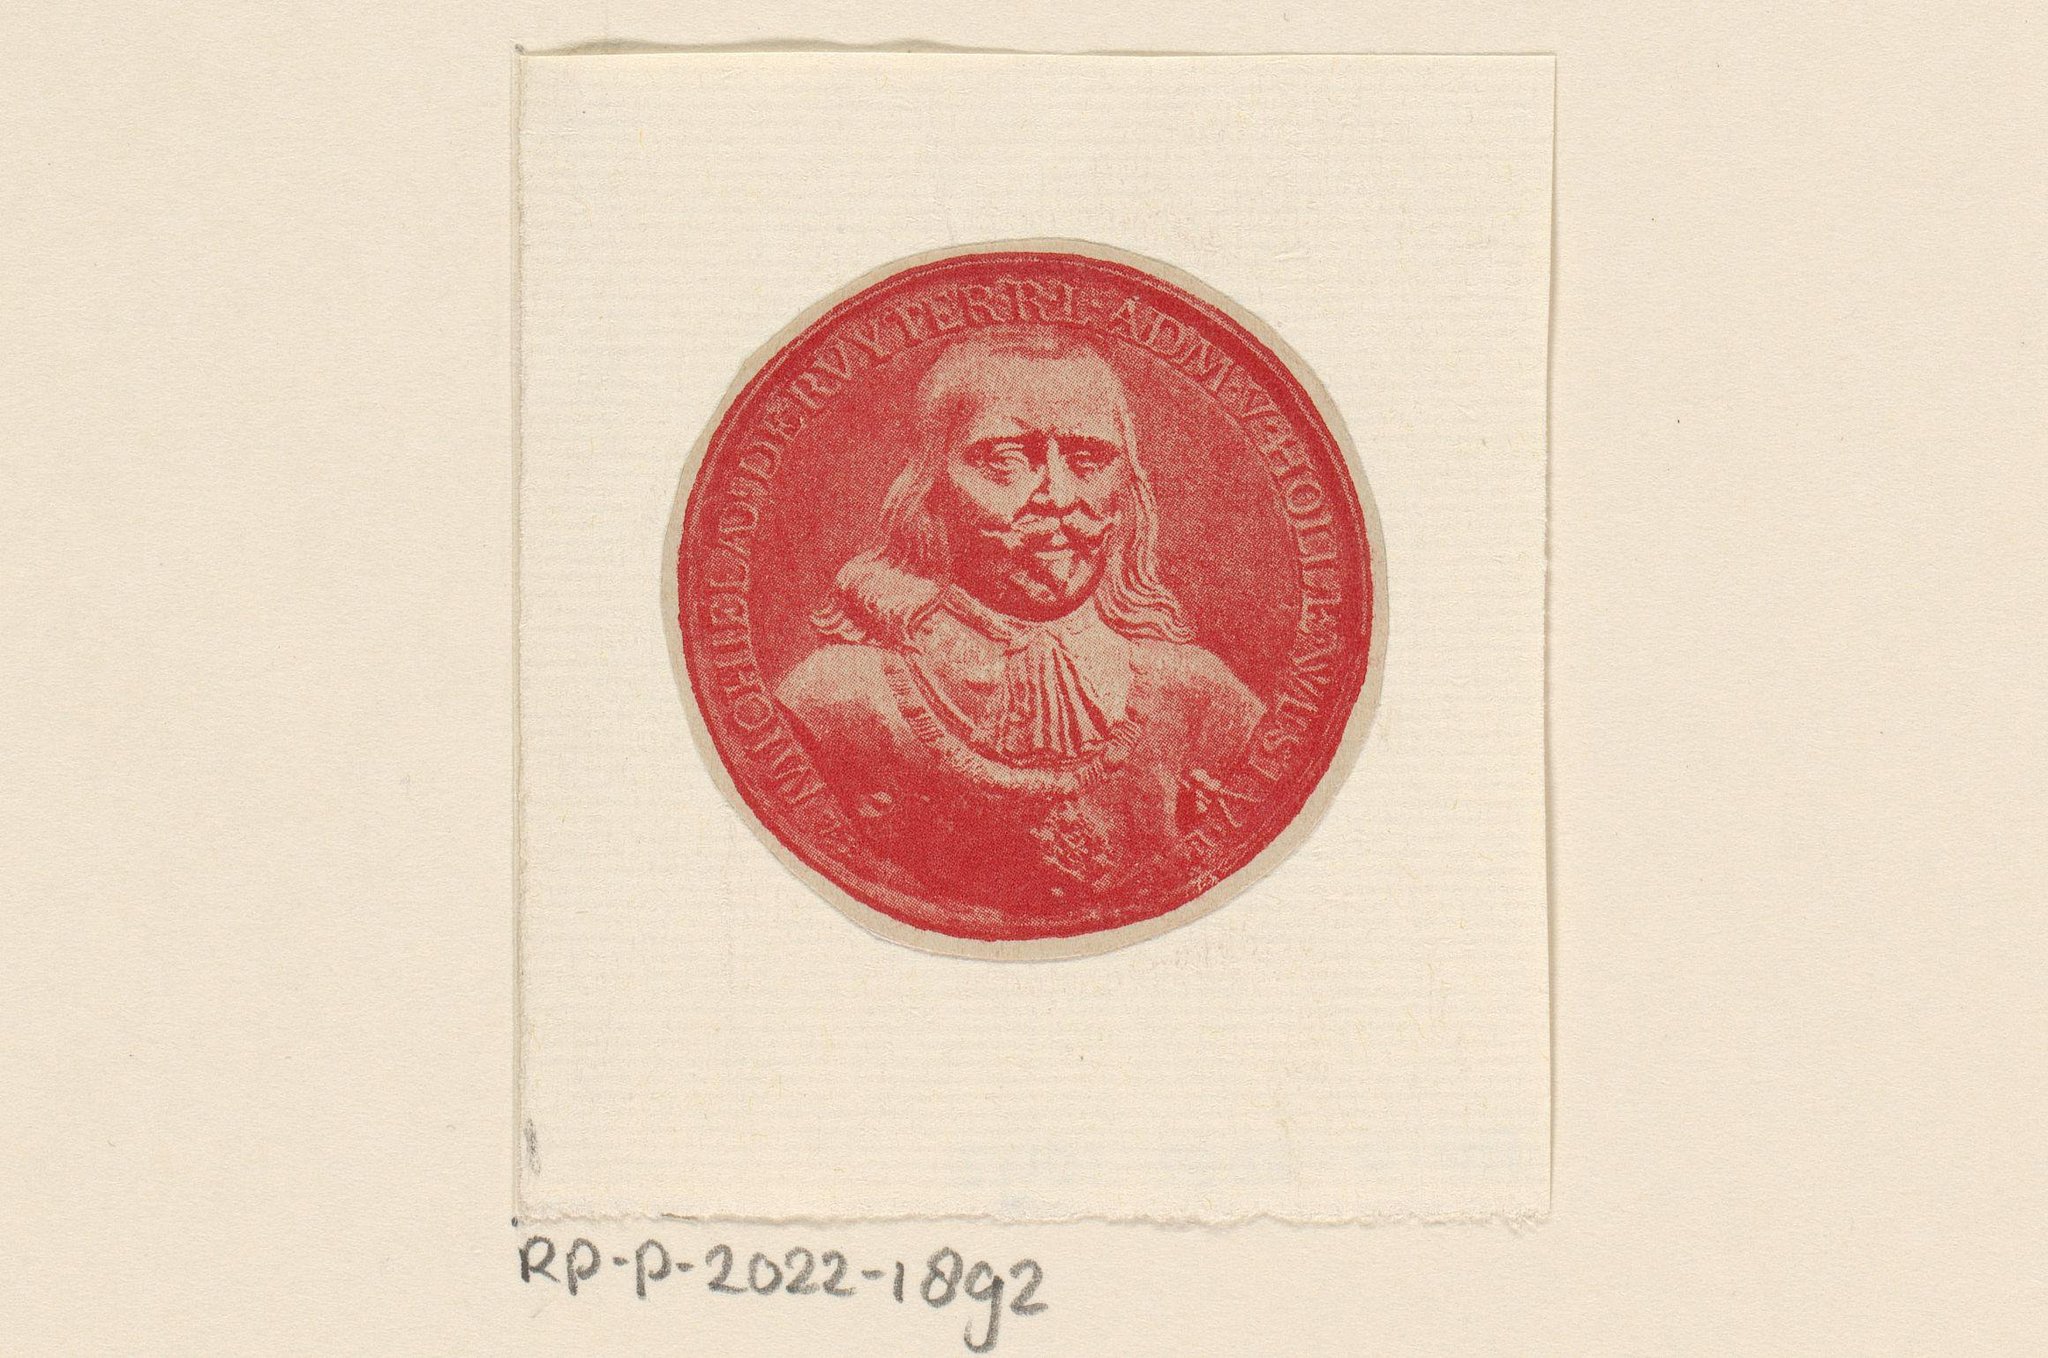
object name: photomechanical print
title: Voorzijde van een penning met het portret van Michiel Adriaenszoon de Ruyter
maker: Anonymous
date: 1882-1970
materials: paper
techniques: snipping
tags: flushing, michiel adriaenszoon de ruyter, ornament ~ medallion, historical persons, commander-in-chief, admiral